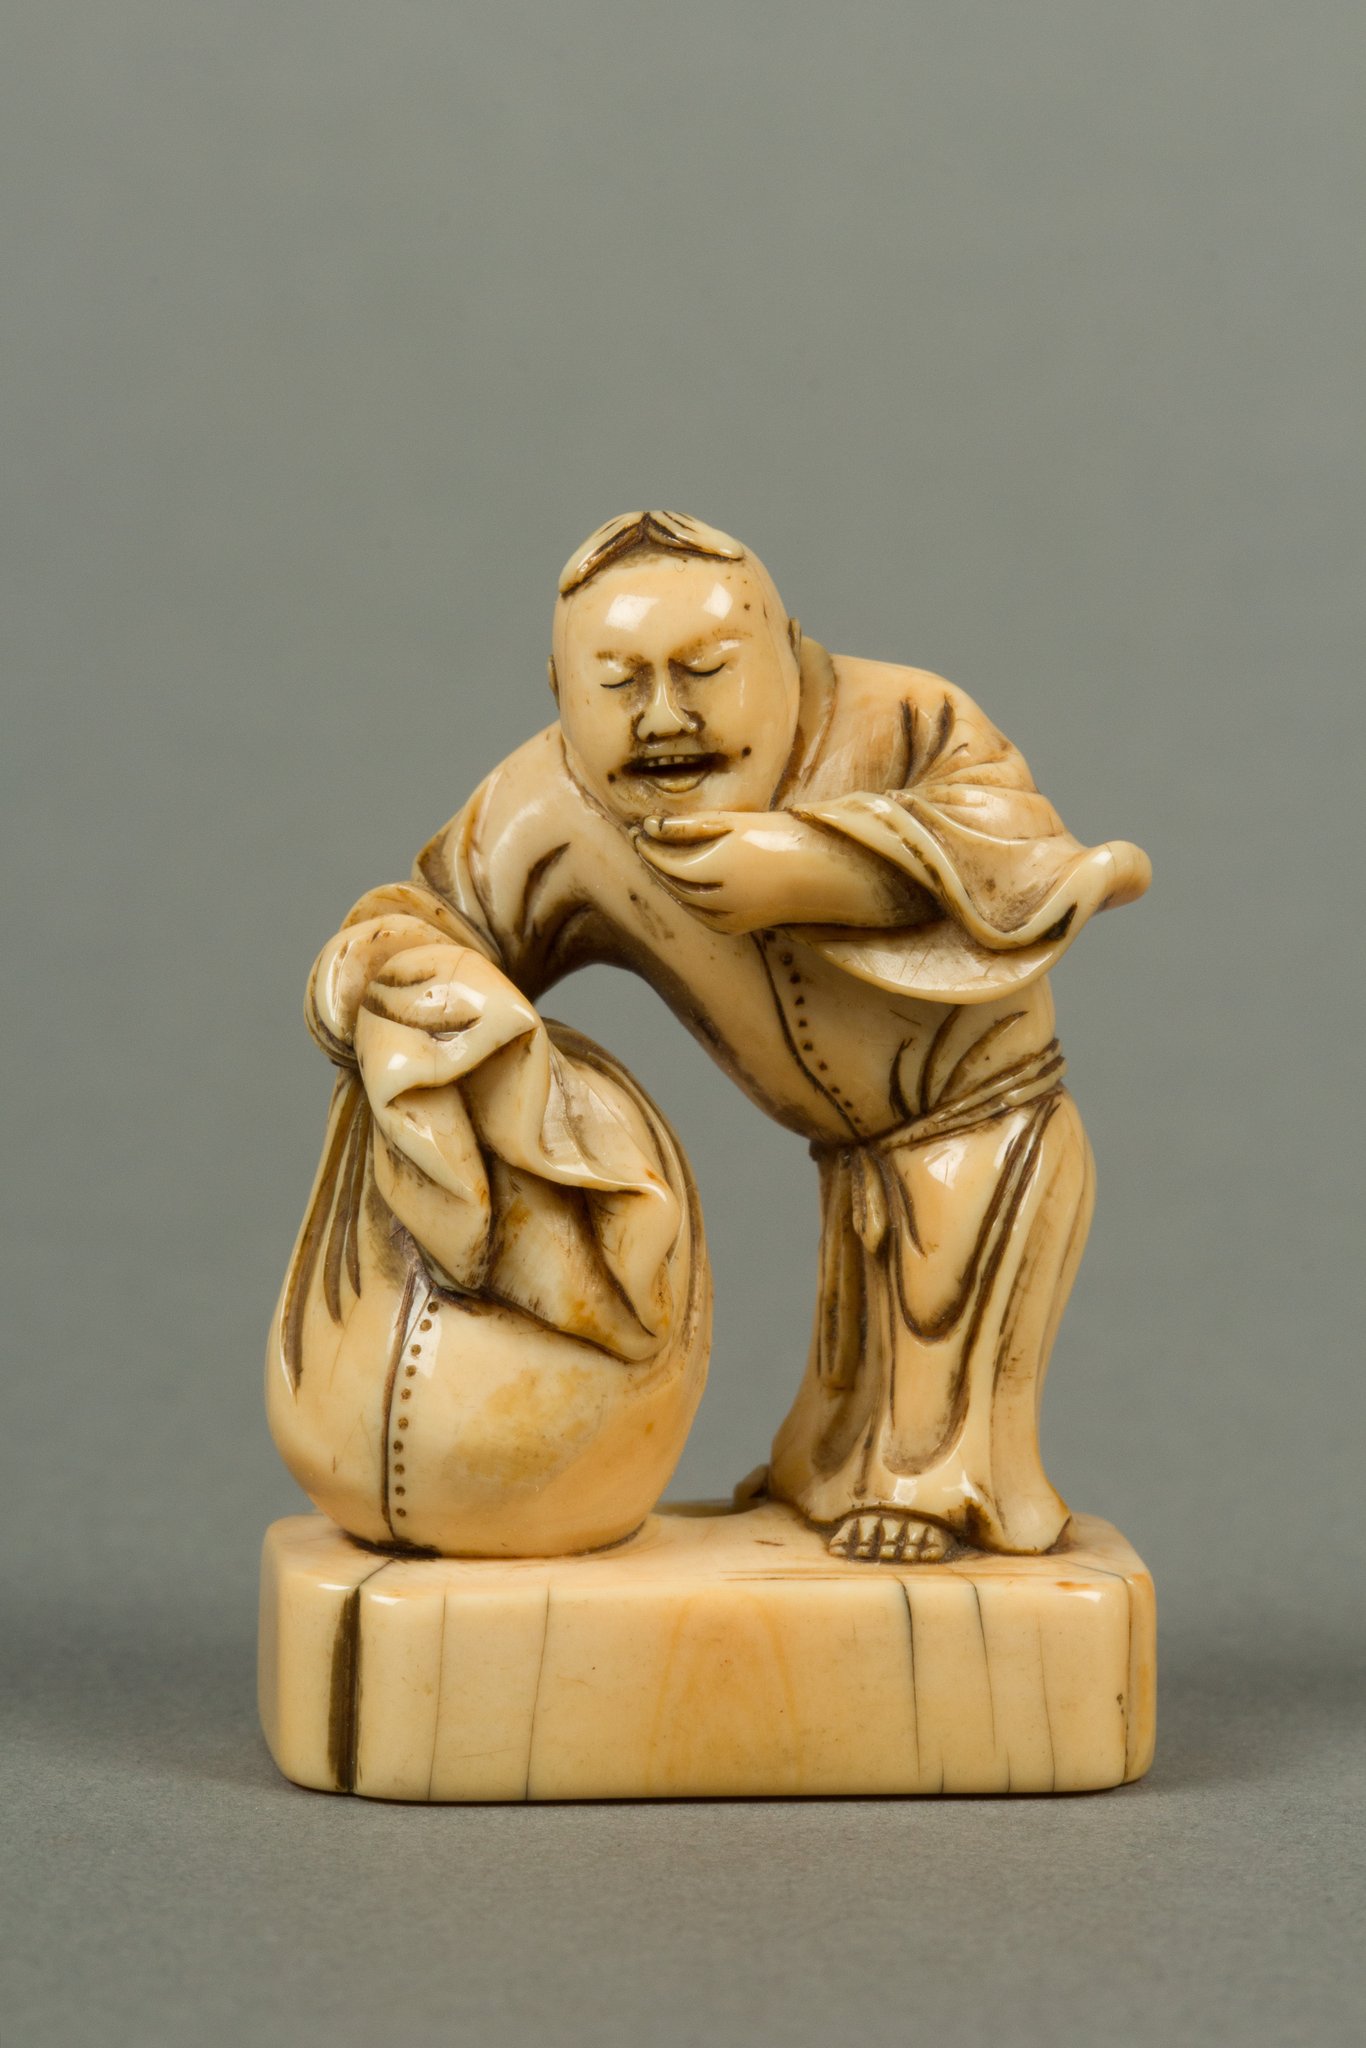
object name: netsuke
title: Netsuke of Man with a Bag, Standing on a Block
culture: japanese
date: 1801-1900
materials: ivory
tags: men